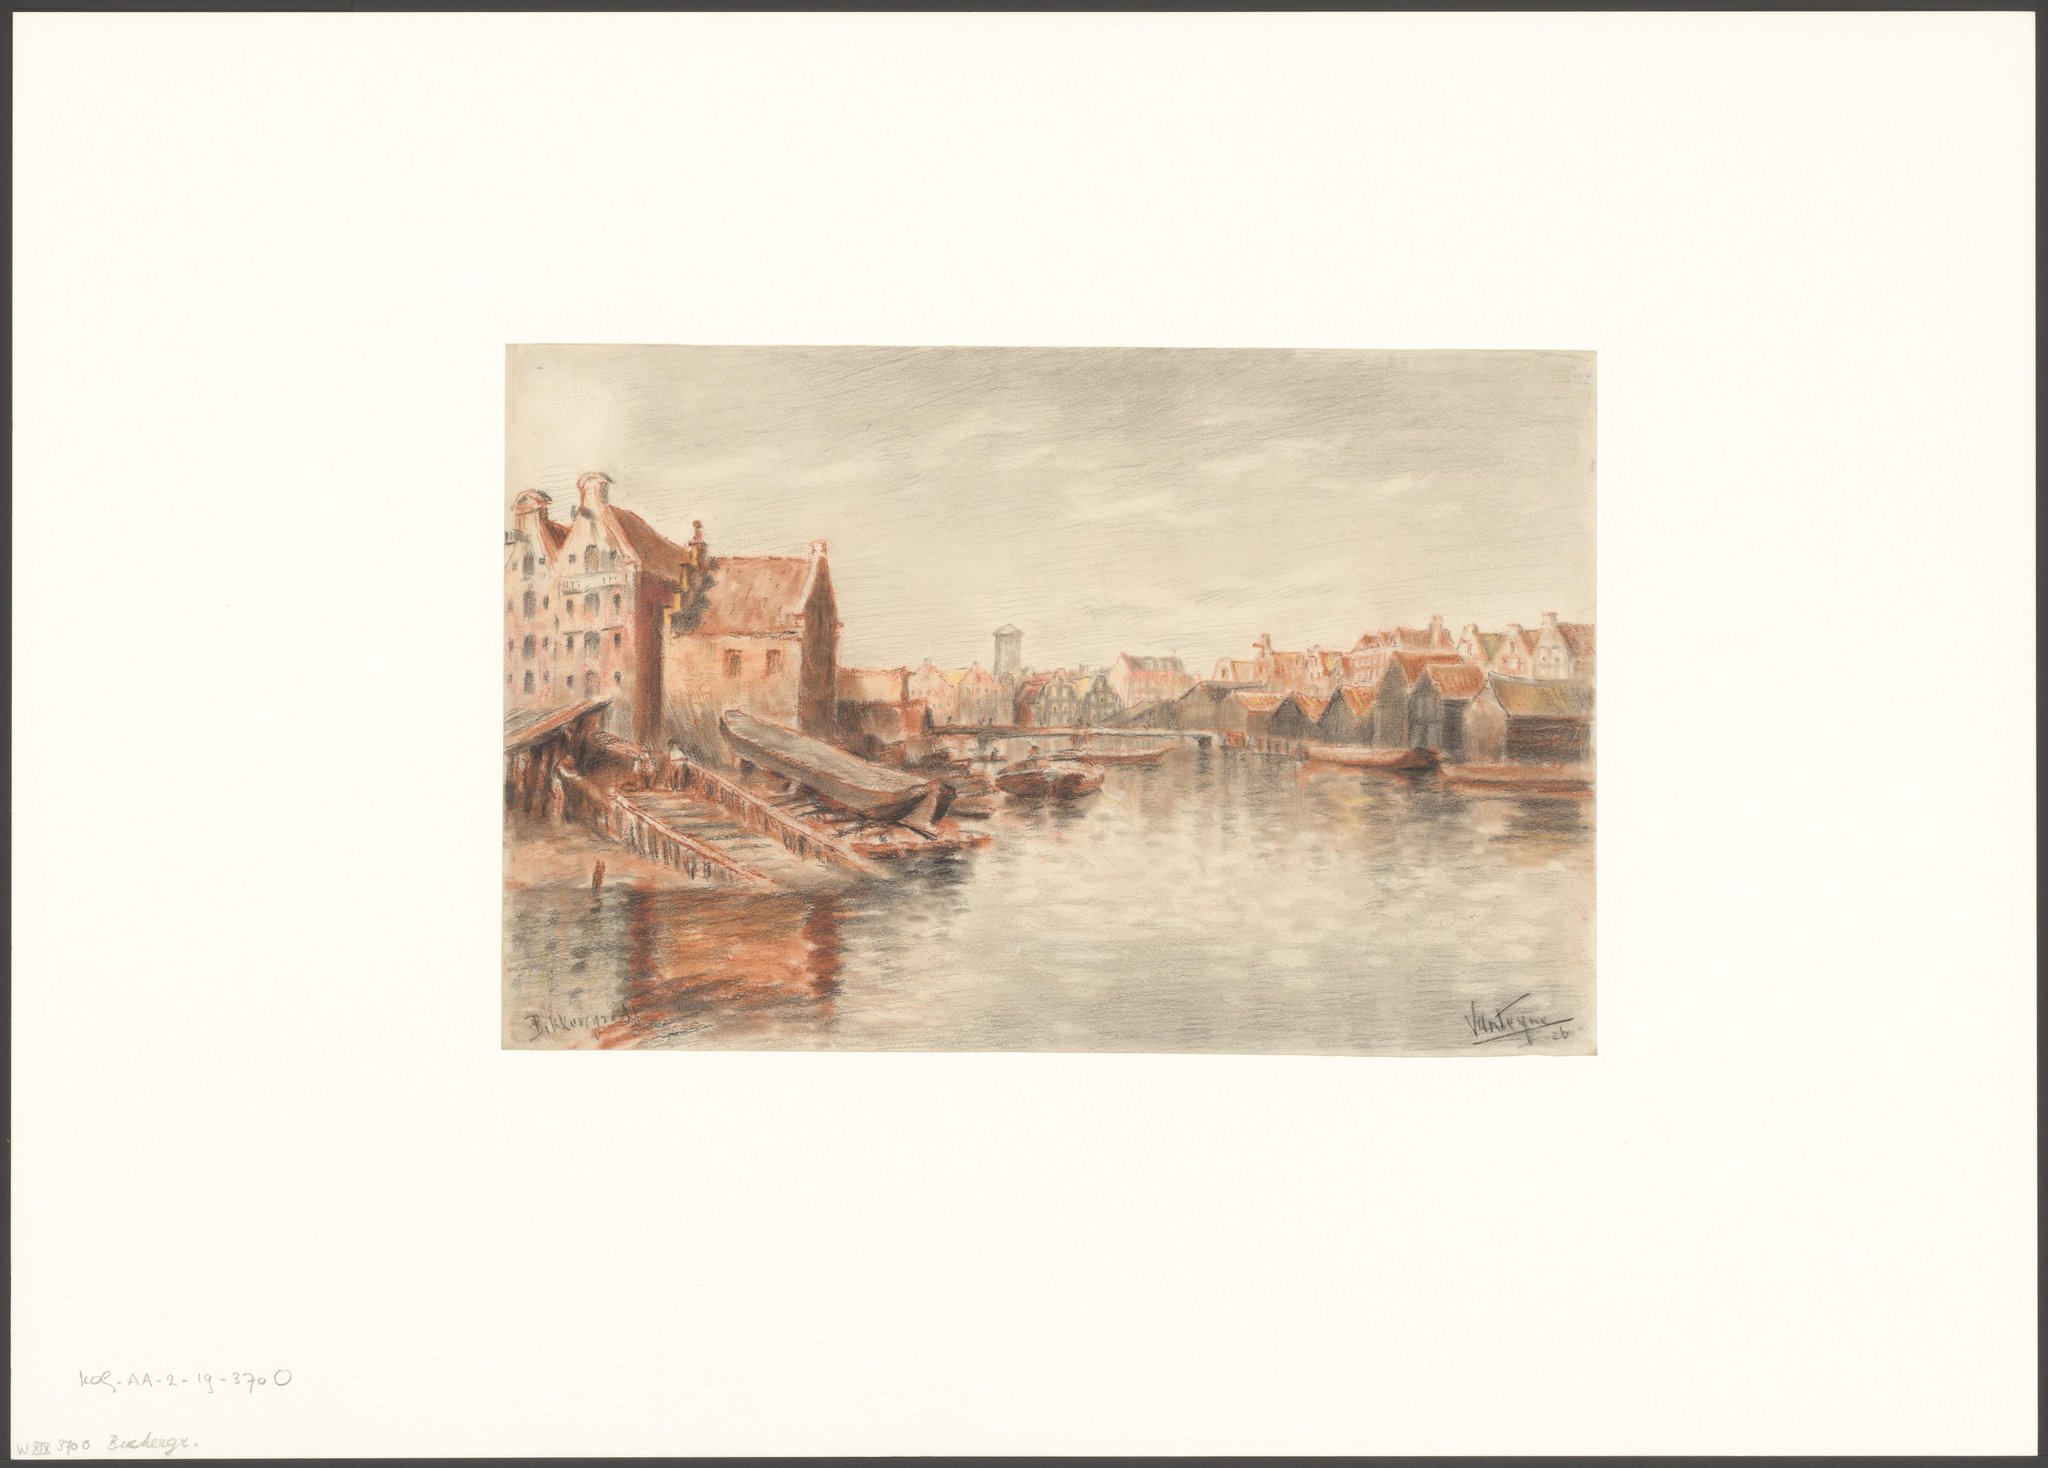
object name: drawing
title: Gezicht op de Bickersgracht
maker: anthonie van teijn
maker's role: draughtsman, painter, print maker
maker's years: 1863-1943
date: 1926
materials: chalk, paper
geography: amsterdam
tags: city-view in general; 'veduta', canal, bridge in city across river, canal, etc., boat propelled by man or animal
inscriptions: signature, date and inscription: ‘Bikkersgracht / VanTeyne / 26’, stamp: ‘J. van Eck.’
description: Tekening binnen de Atlas Van Eck ingedeeld op wijknummer 19.